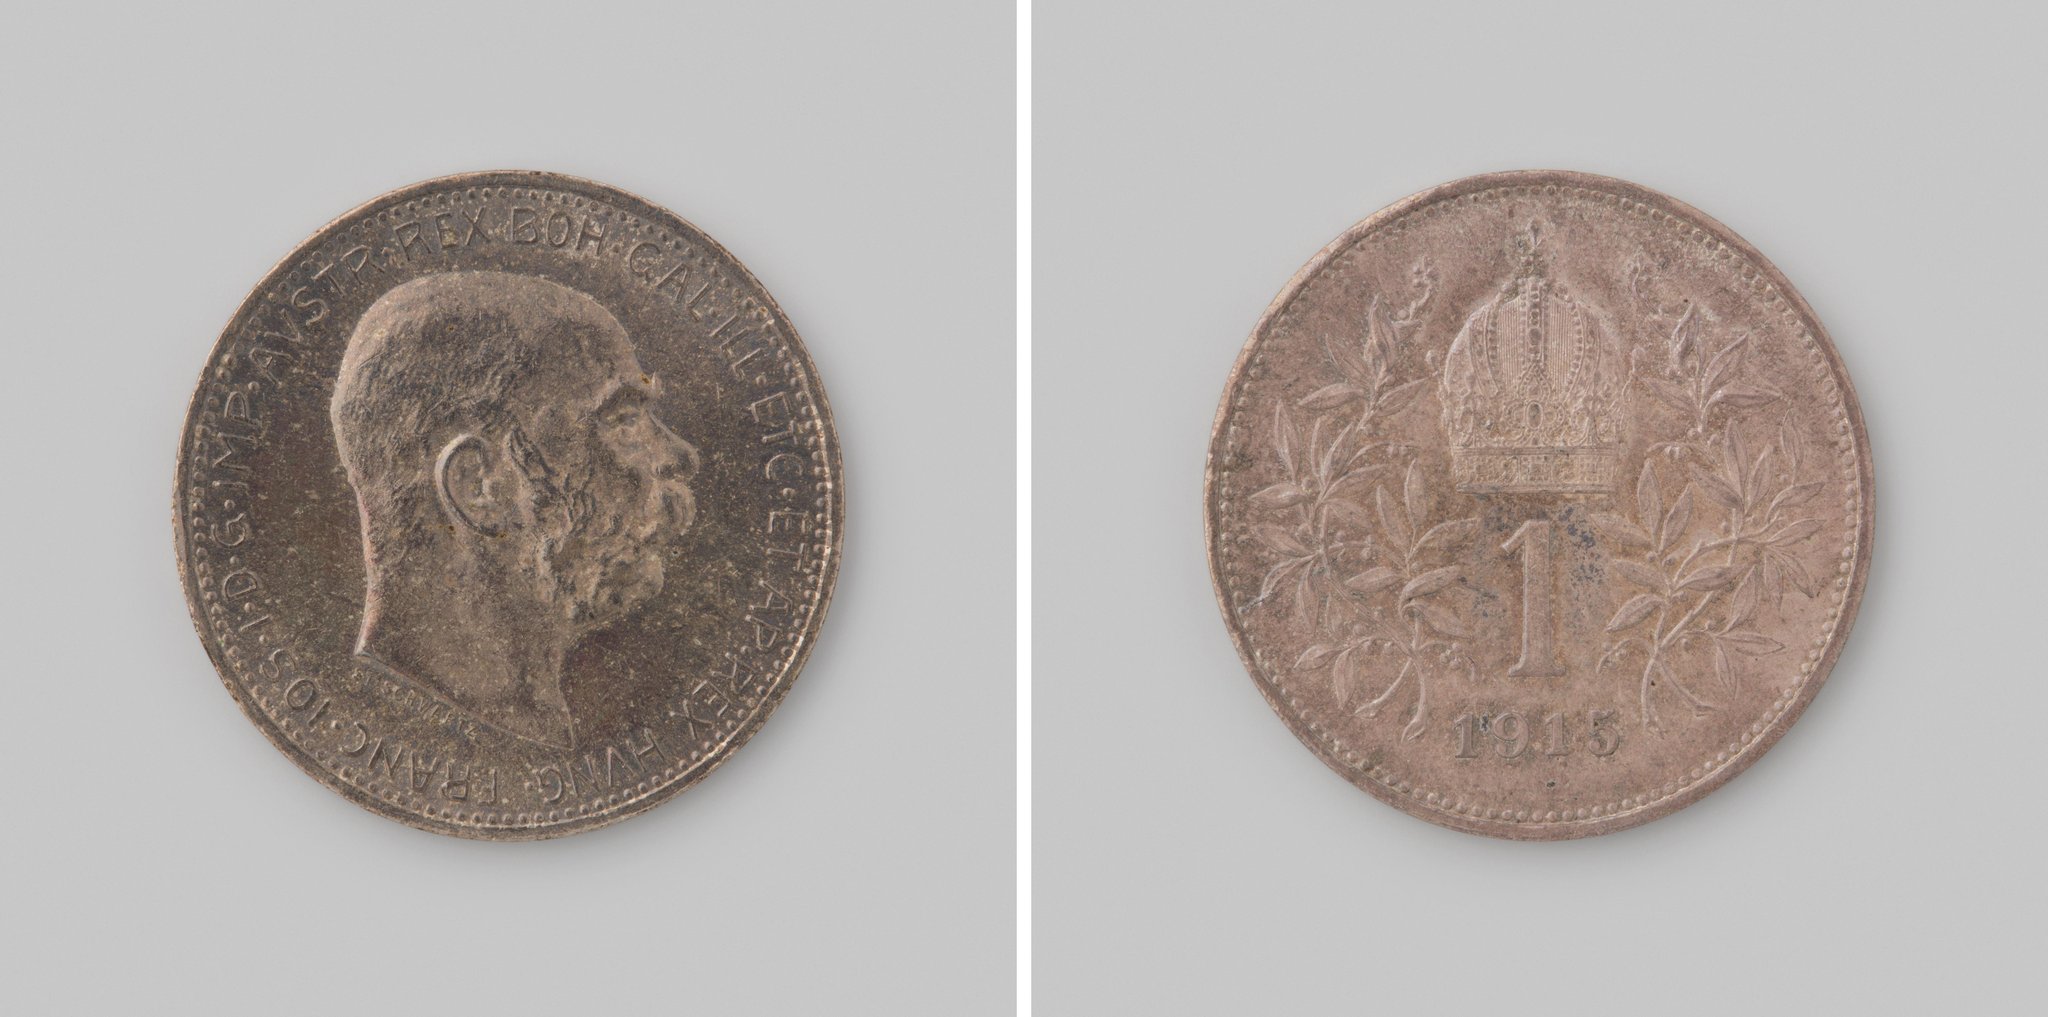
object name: coin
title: Krone uit het keizerrijk Oostenrijk van Franz Joseph,1915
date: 1915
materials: silver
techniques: striking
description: Zilveren munt. Voorzijde: hoofd van de keizer naar rechts. Keerzijde: tussen twee takken waarde-aanduiding, waarboven keizerskroon en waaronder jaartal. Randschrift.